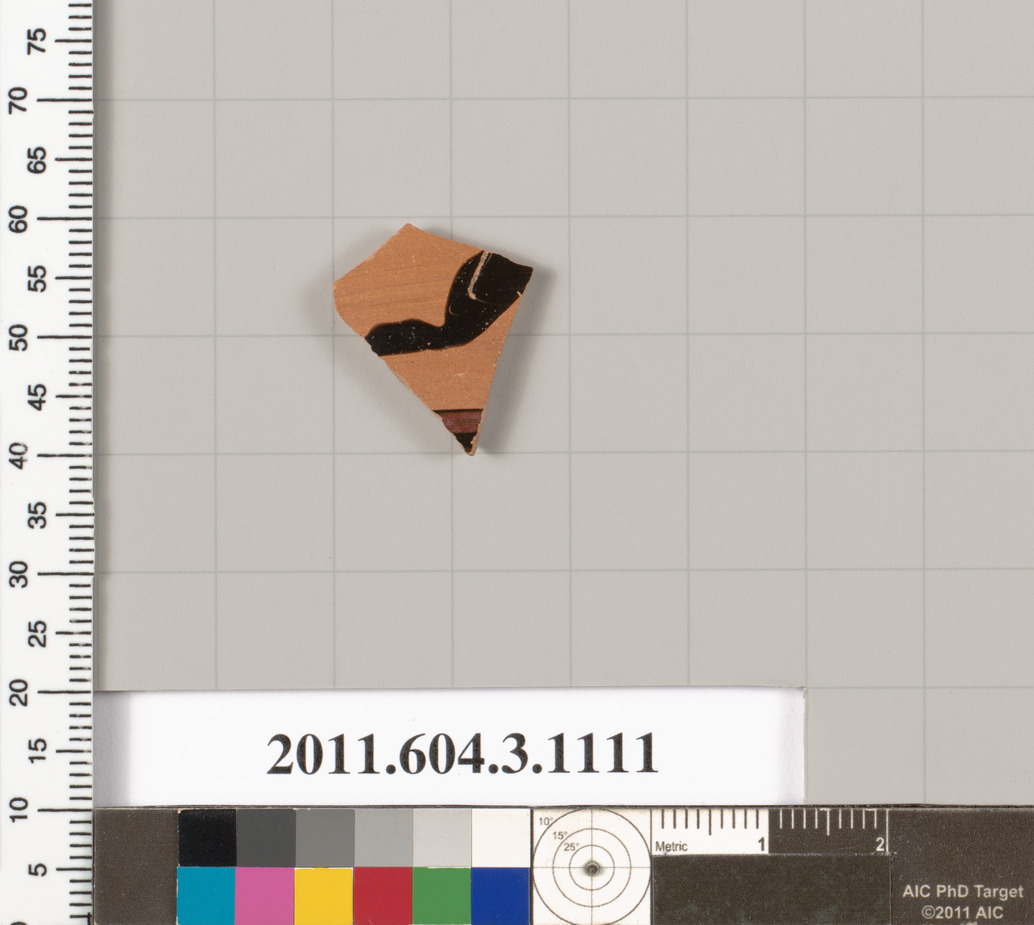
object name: mastoid or kyathos fragment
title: Terracotta fragment of a mastoid (drinking cup with narrow base) or a kyathos (cup-shaped ladle)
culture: greek, attic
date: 534-468 BCE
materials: terracotta